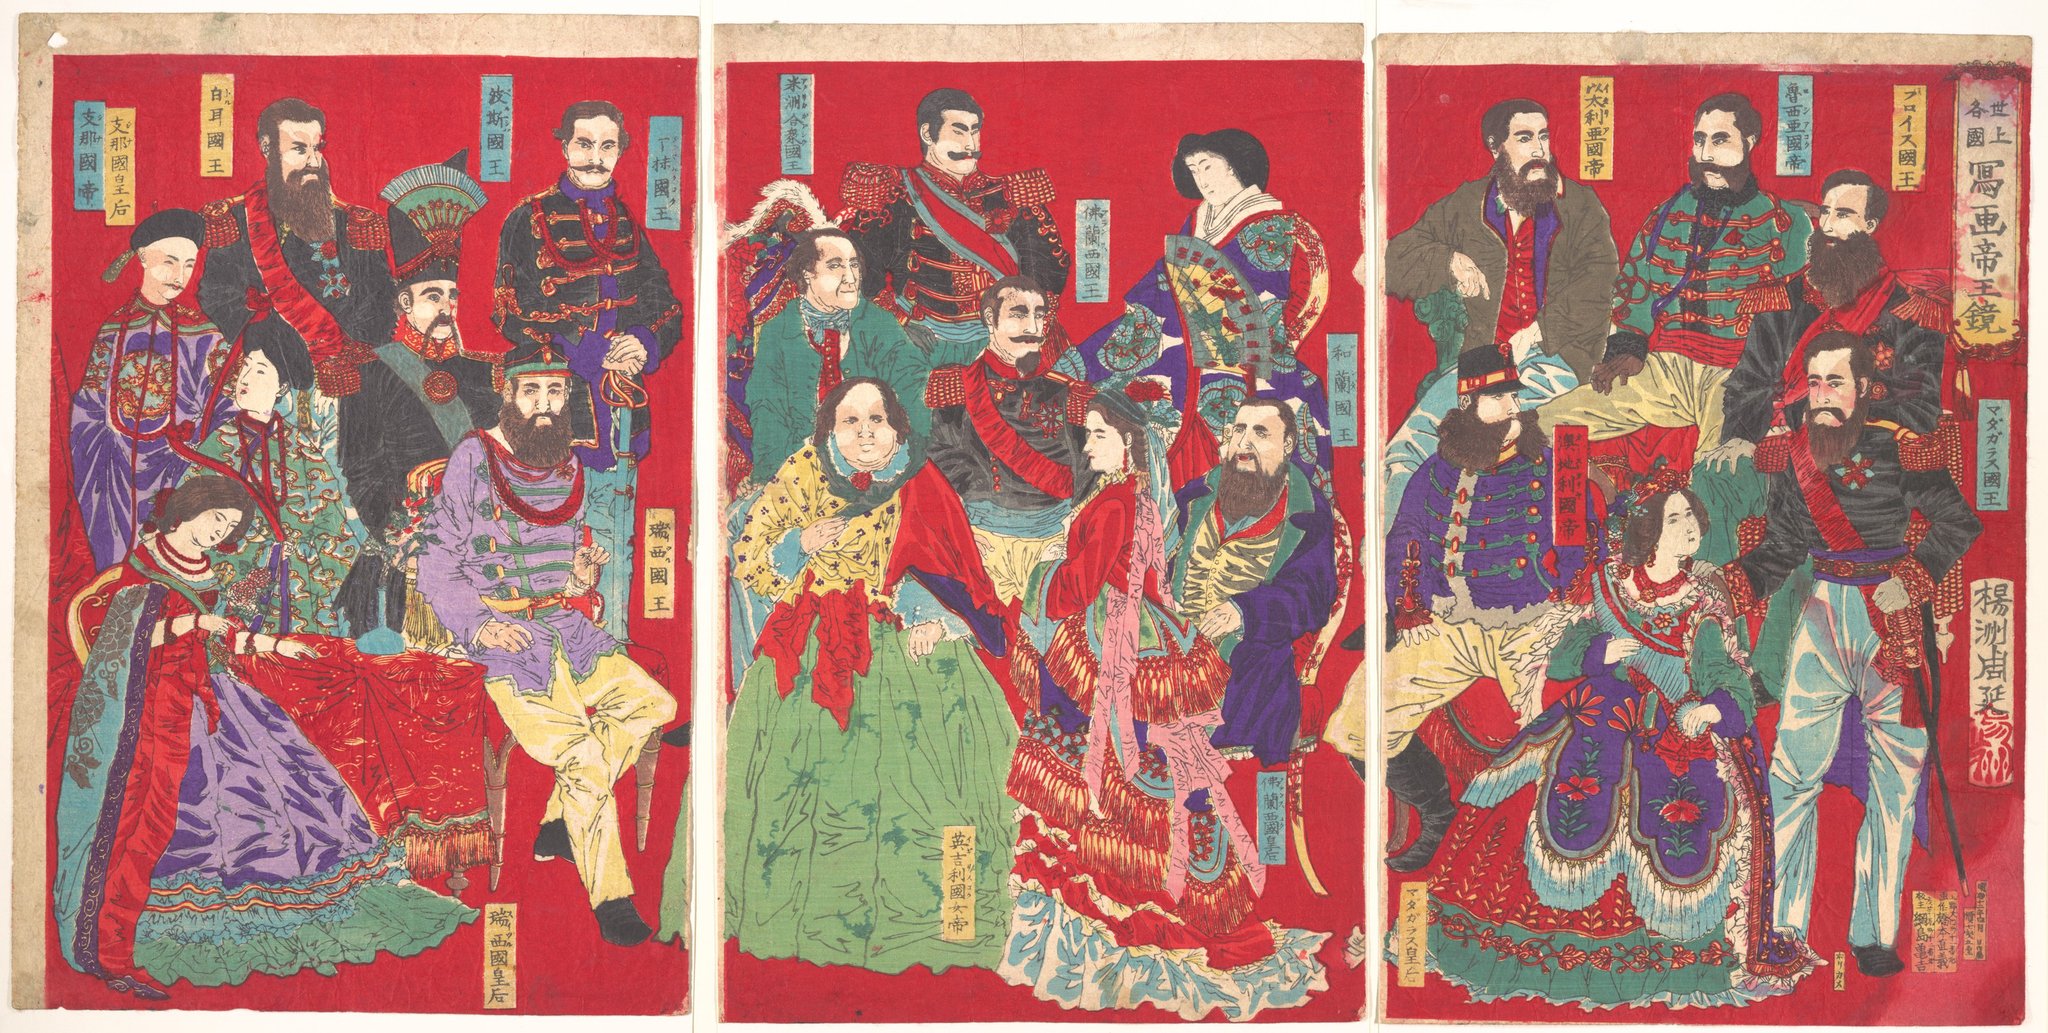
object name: print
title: Mirror of Portraits of All Sovereigns in the World (Sejō kakkoku shaga teiō kagami)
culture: japanese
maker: yōshū (hashimoto) chikanobu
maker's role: artist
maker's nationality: japanese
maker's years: 1838-1912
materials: ink, paper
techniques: woodblock print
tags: men,women